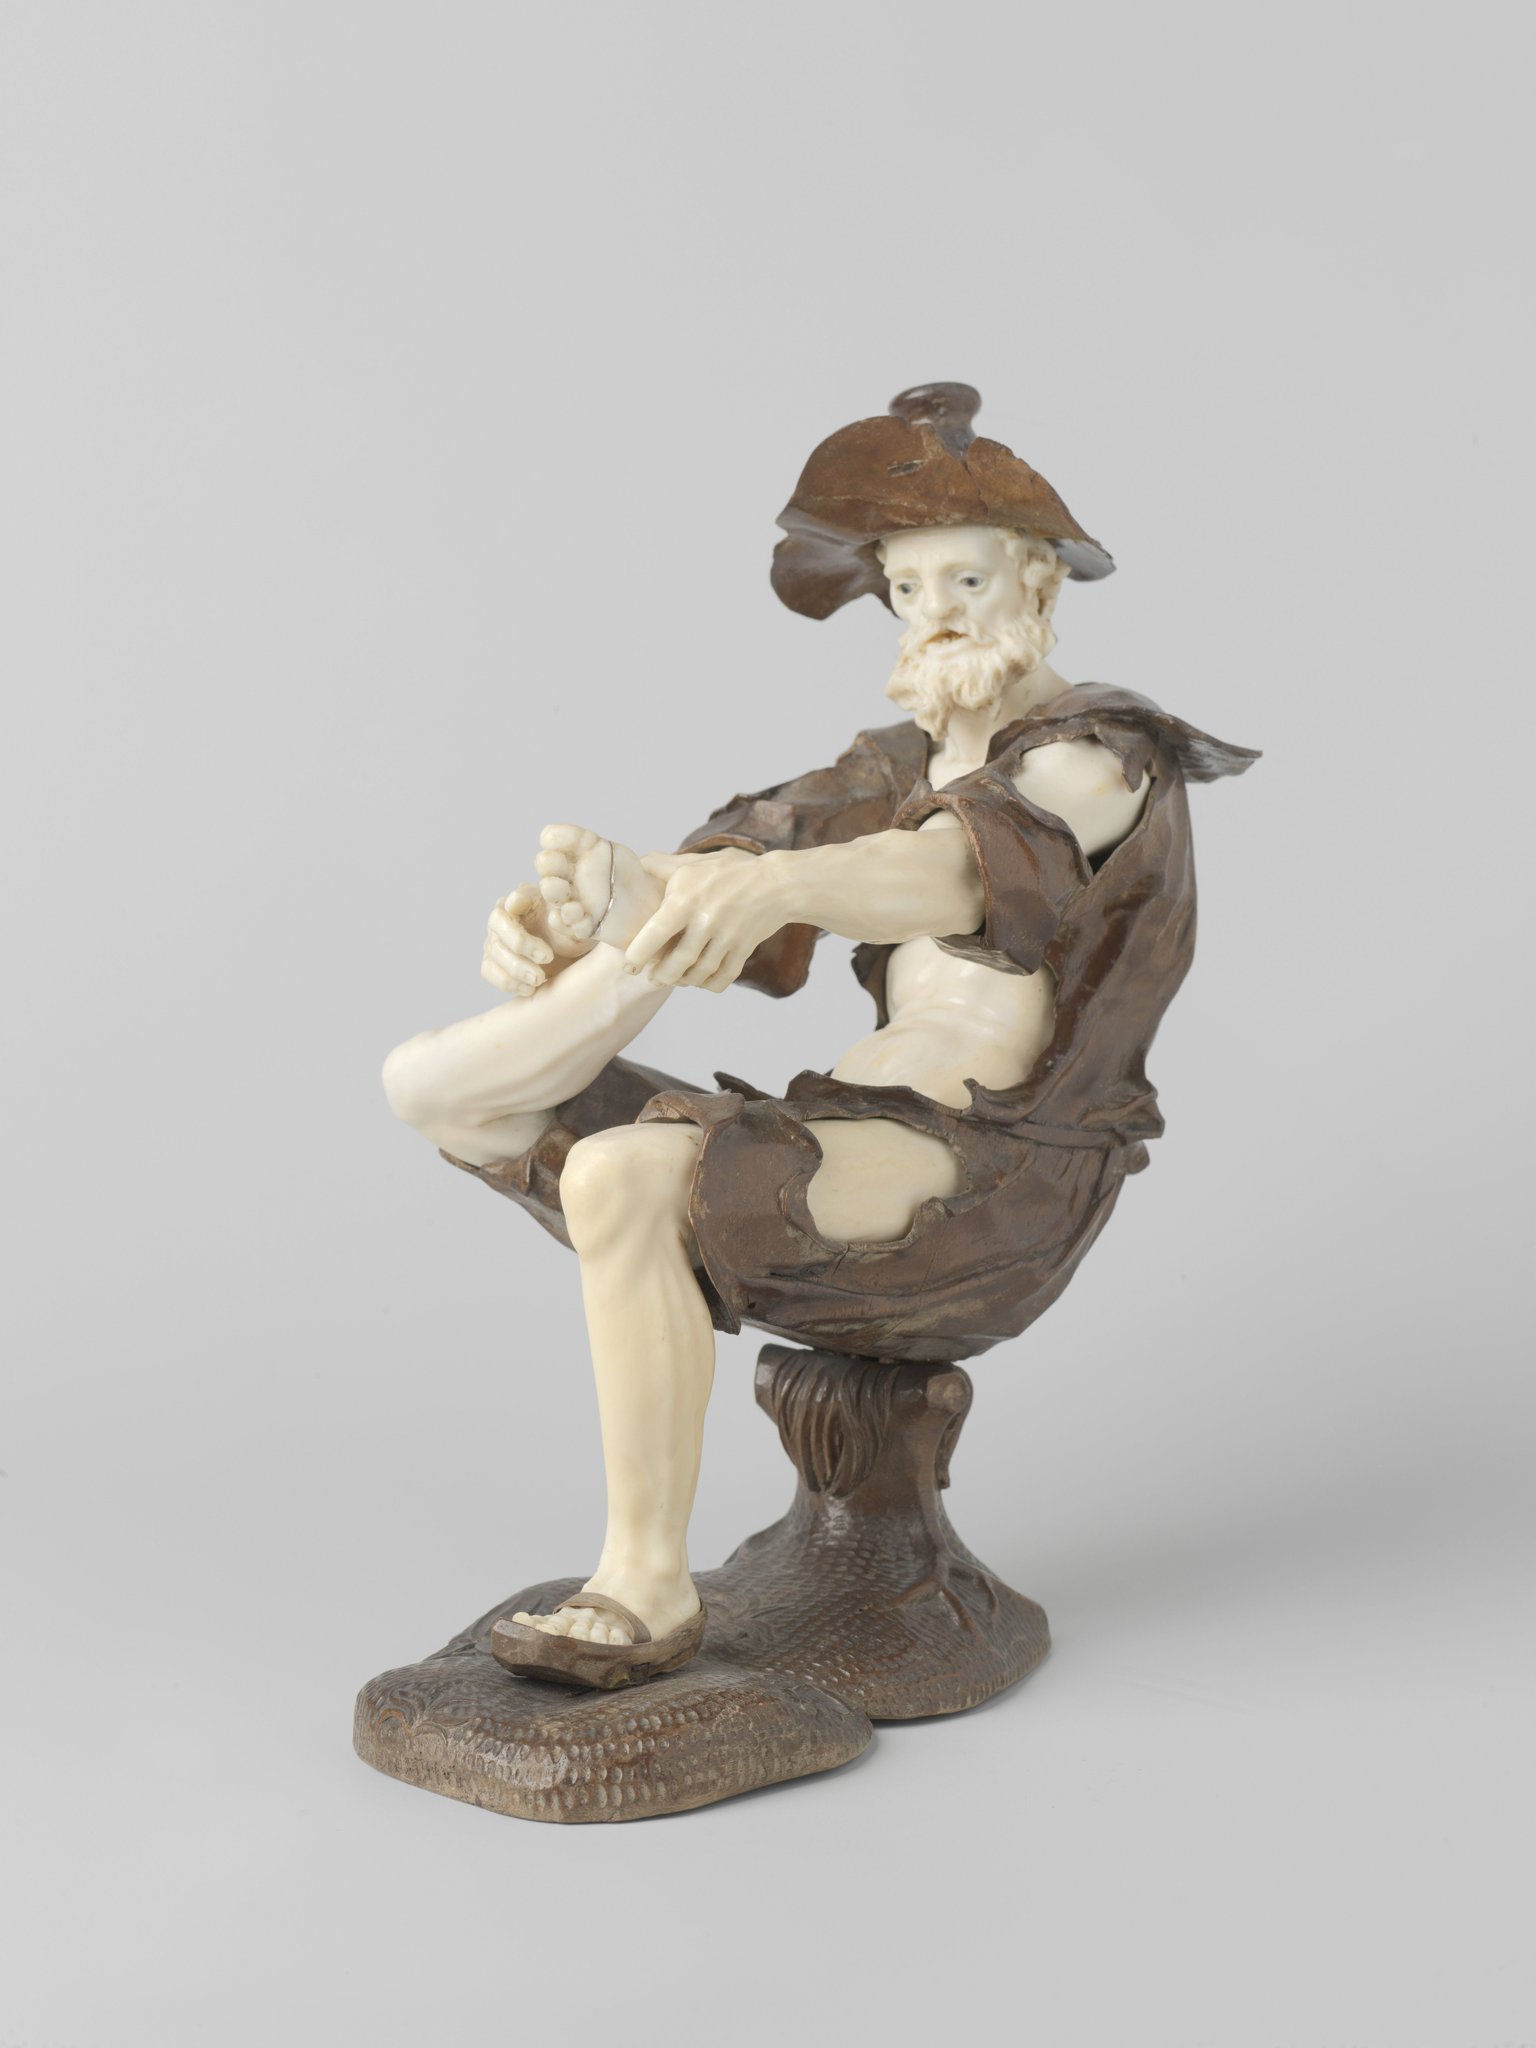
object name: sculpture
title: Zittend bedelende figuur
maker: simon troger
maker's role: sculptor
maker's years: 1693-1768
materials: ivory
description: Zittende bedelaar met de benen over elkaar.